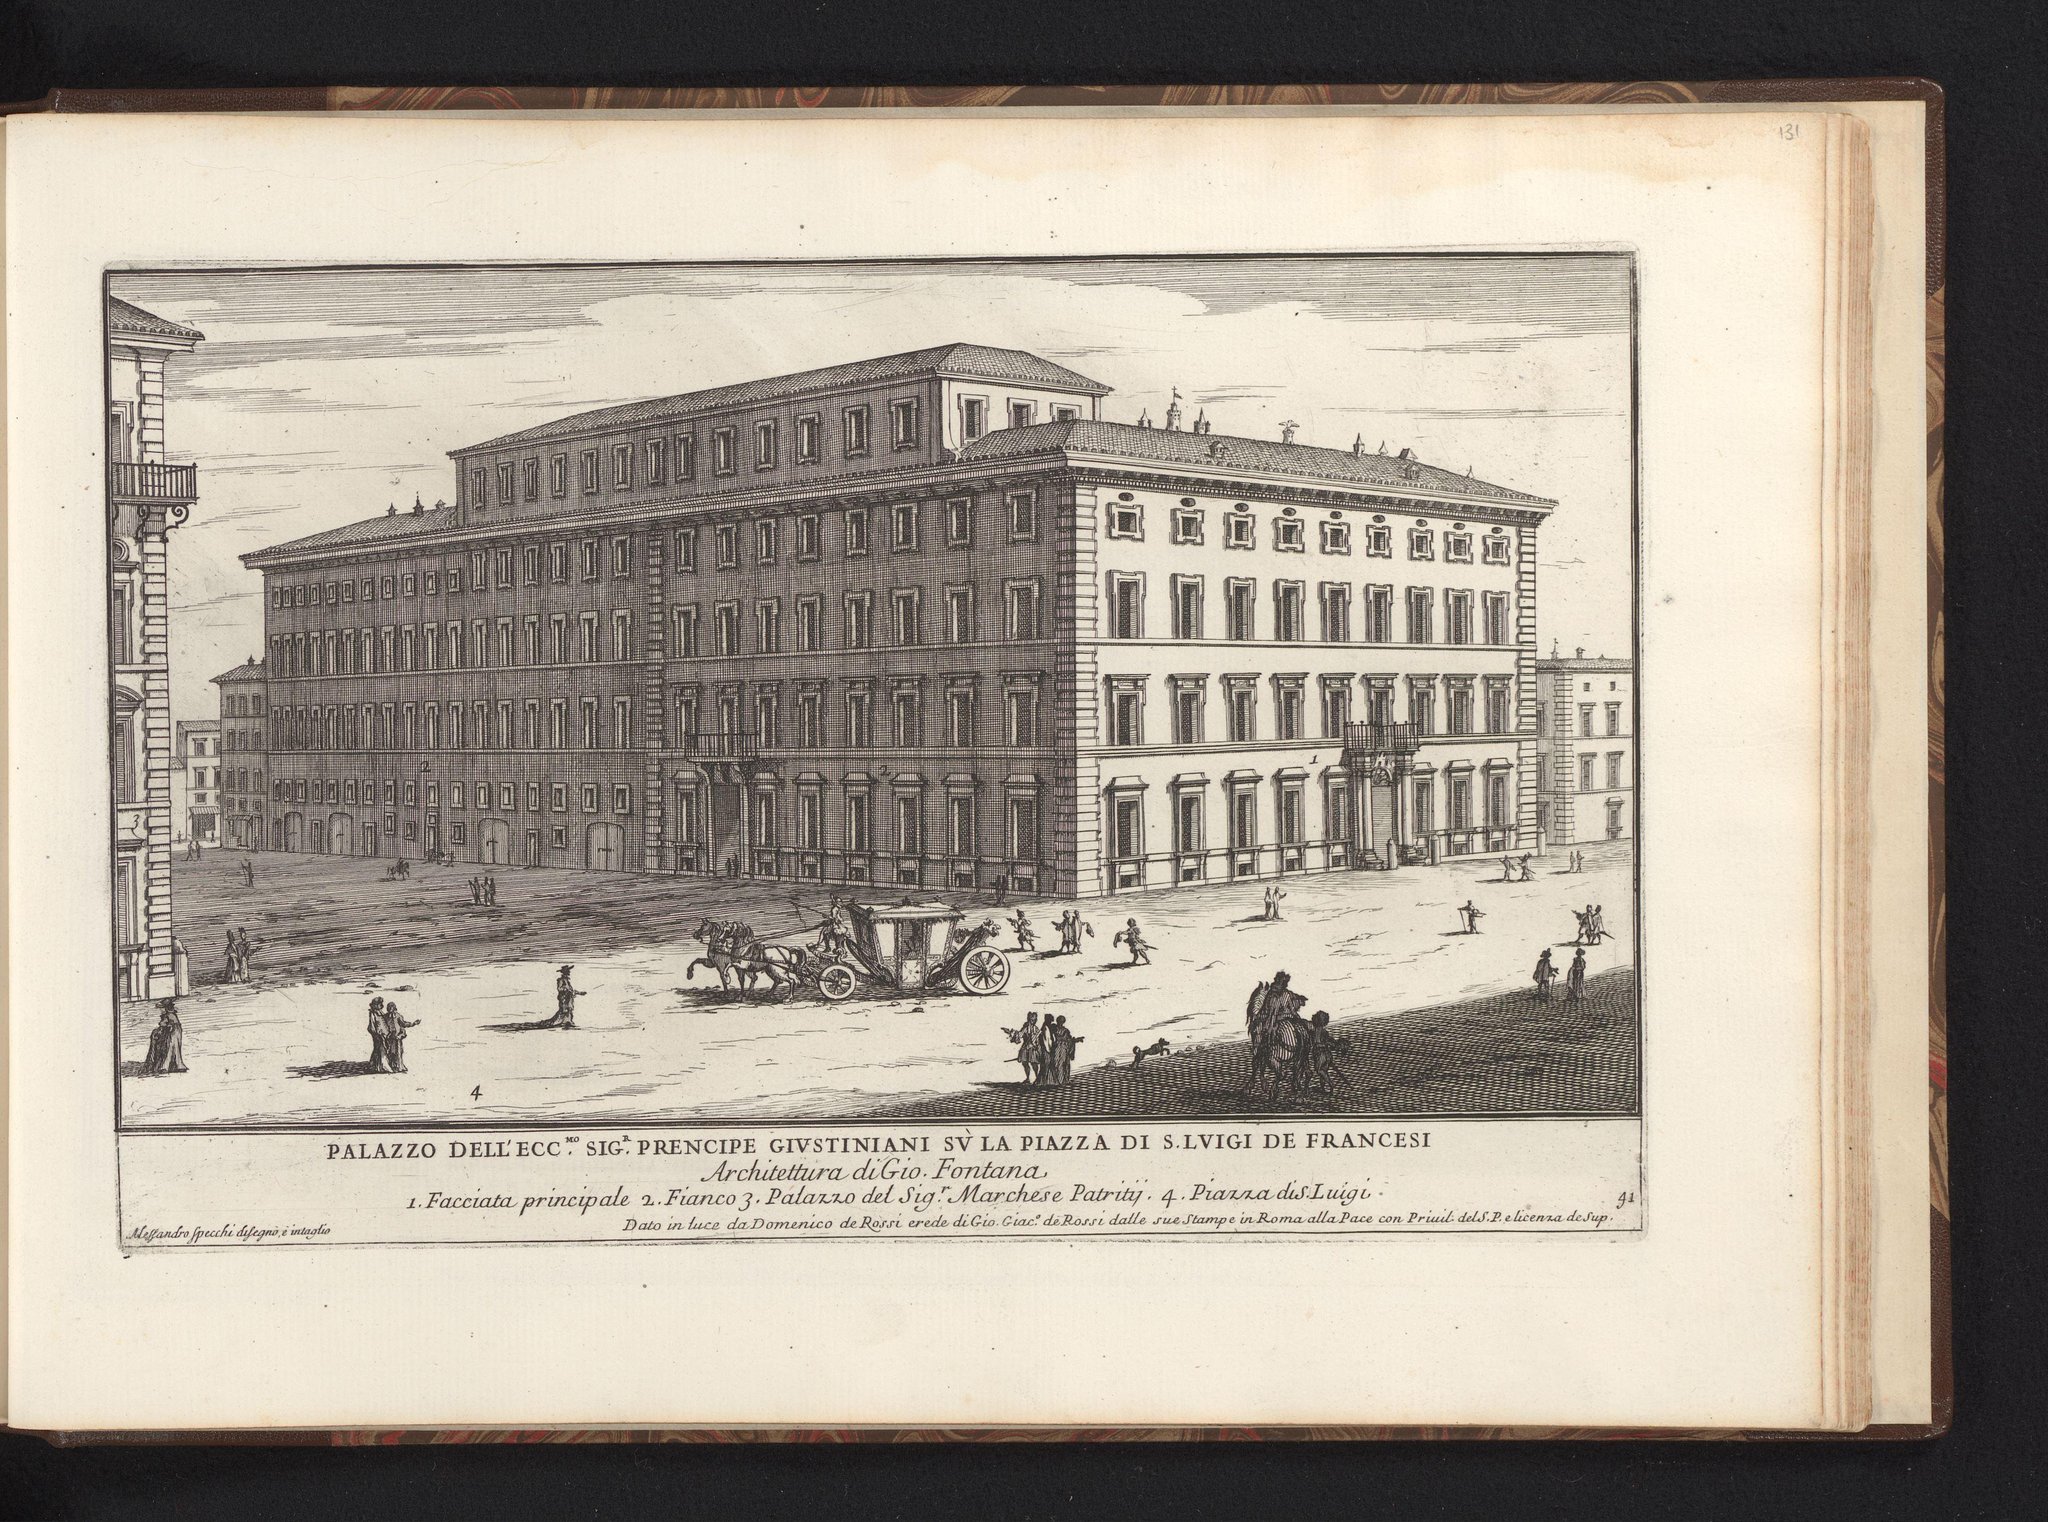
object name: album leaf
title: Palazzo Giustiniani te Rome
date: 1699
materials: paper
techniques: etching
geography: italy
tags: city-view, and landscape with man-made constructions, hôtel, i.e. small palace in city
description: Deze prent maakt deel uit van een reeks van 52 prenten met voorstellingen van paleizen in Rome. Samen met vier andere reeksen vormt het de grote reeks: 'Il nuovo teatro di Roma moderna'.